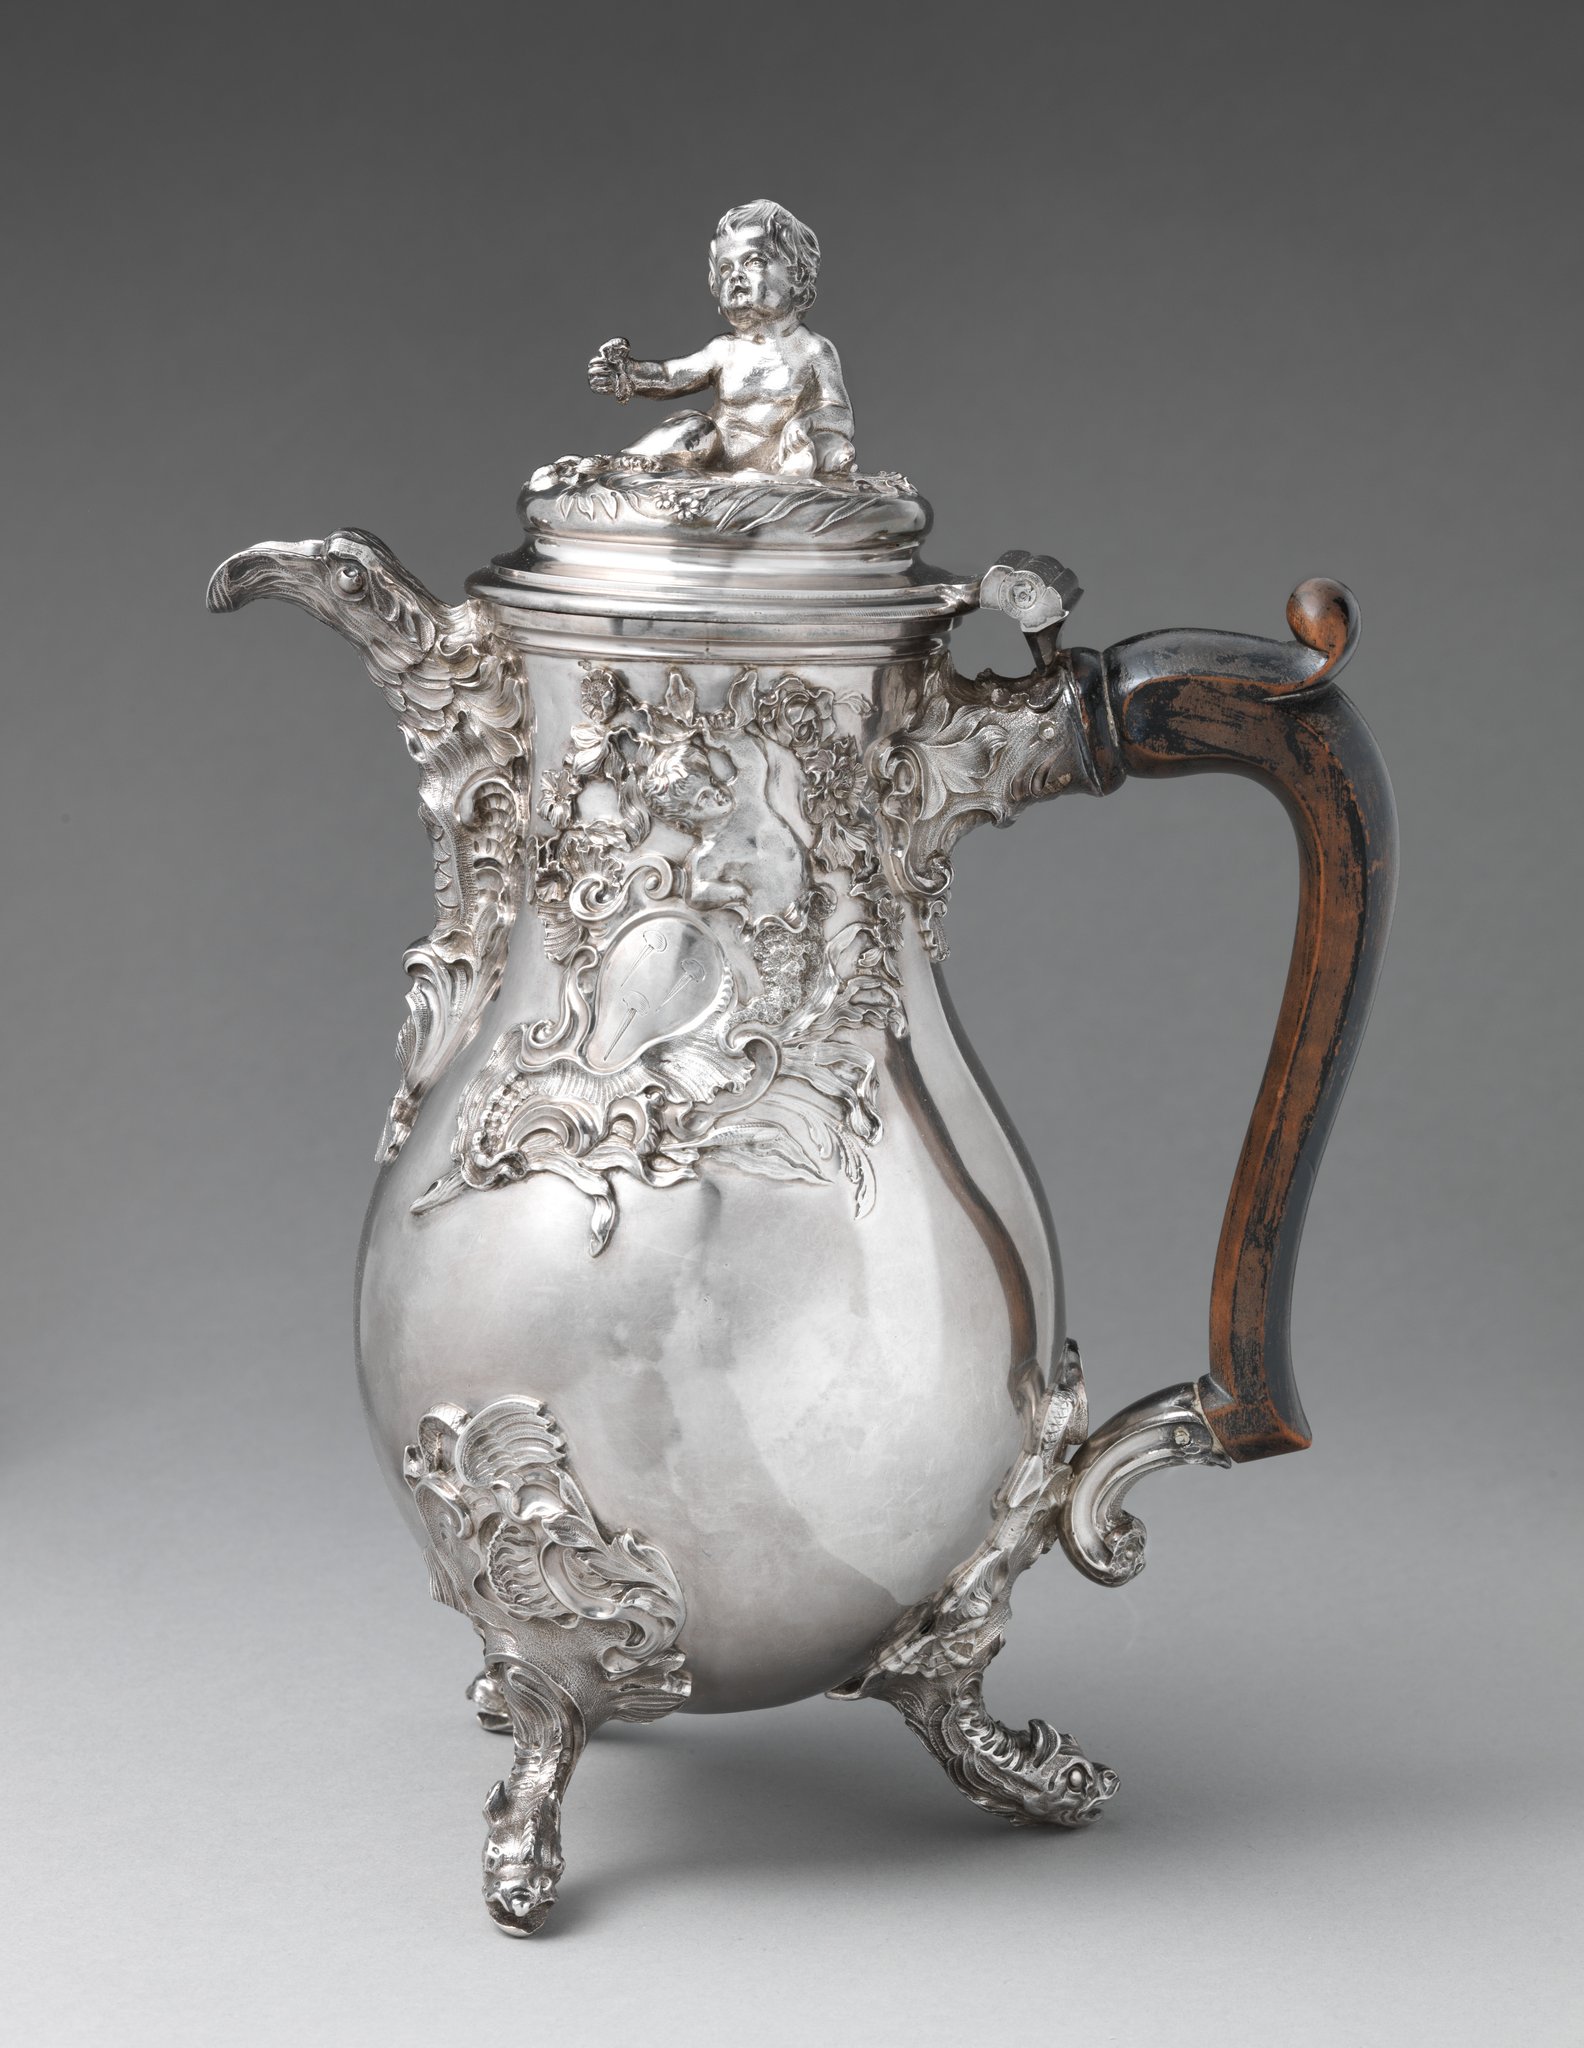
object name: coffeepot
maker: paul de lamerie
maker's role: maker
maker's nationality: british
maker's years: 1688-1751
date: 1737-1738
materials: silver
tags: infants,flowers